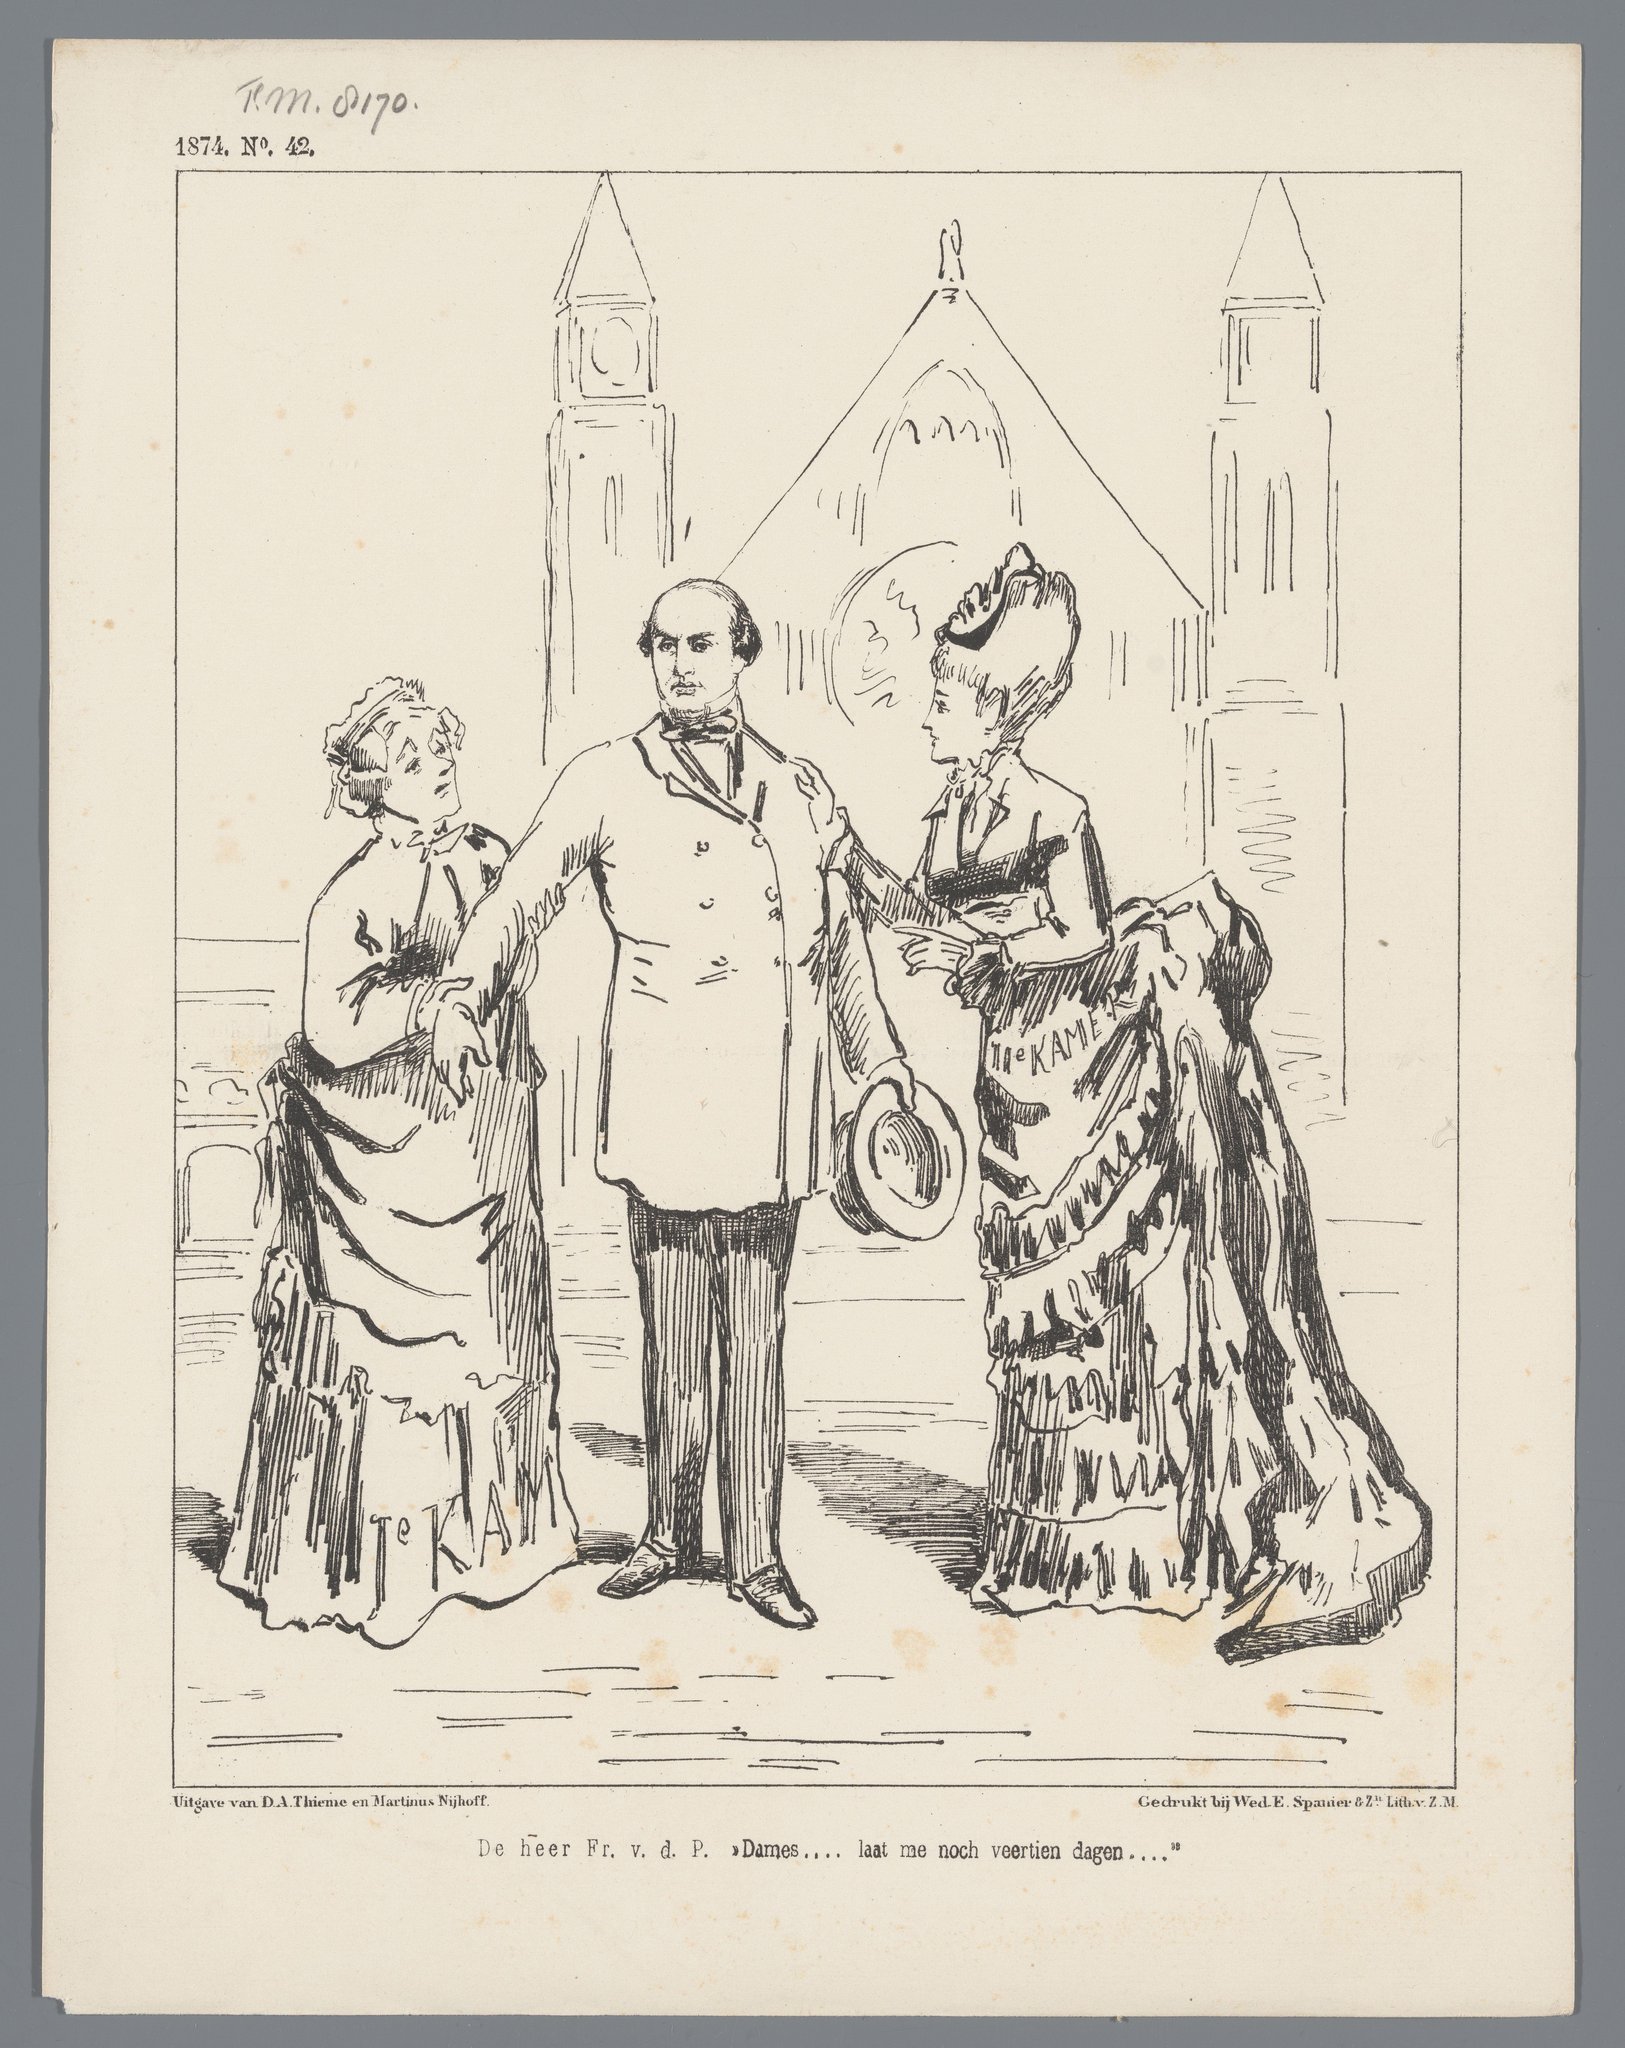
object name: print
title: Spotprent waarin Fransen van de Putte verzocht wordt om lid te worden, 1874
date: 1874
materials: paper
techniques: lithograph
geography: netherlands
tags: the hague, politician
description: Spotprent waarin Fransen van de Putte door de Eerste en Tweede Kamer verzocht wordt om lid te worden, 1874. Plaat verschenen bij het weekblad De Nederlandsche Spectator, nr. 42, 1874.